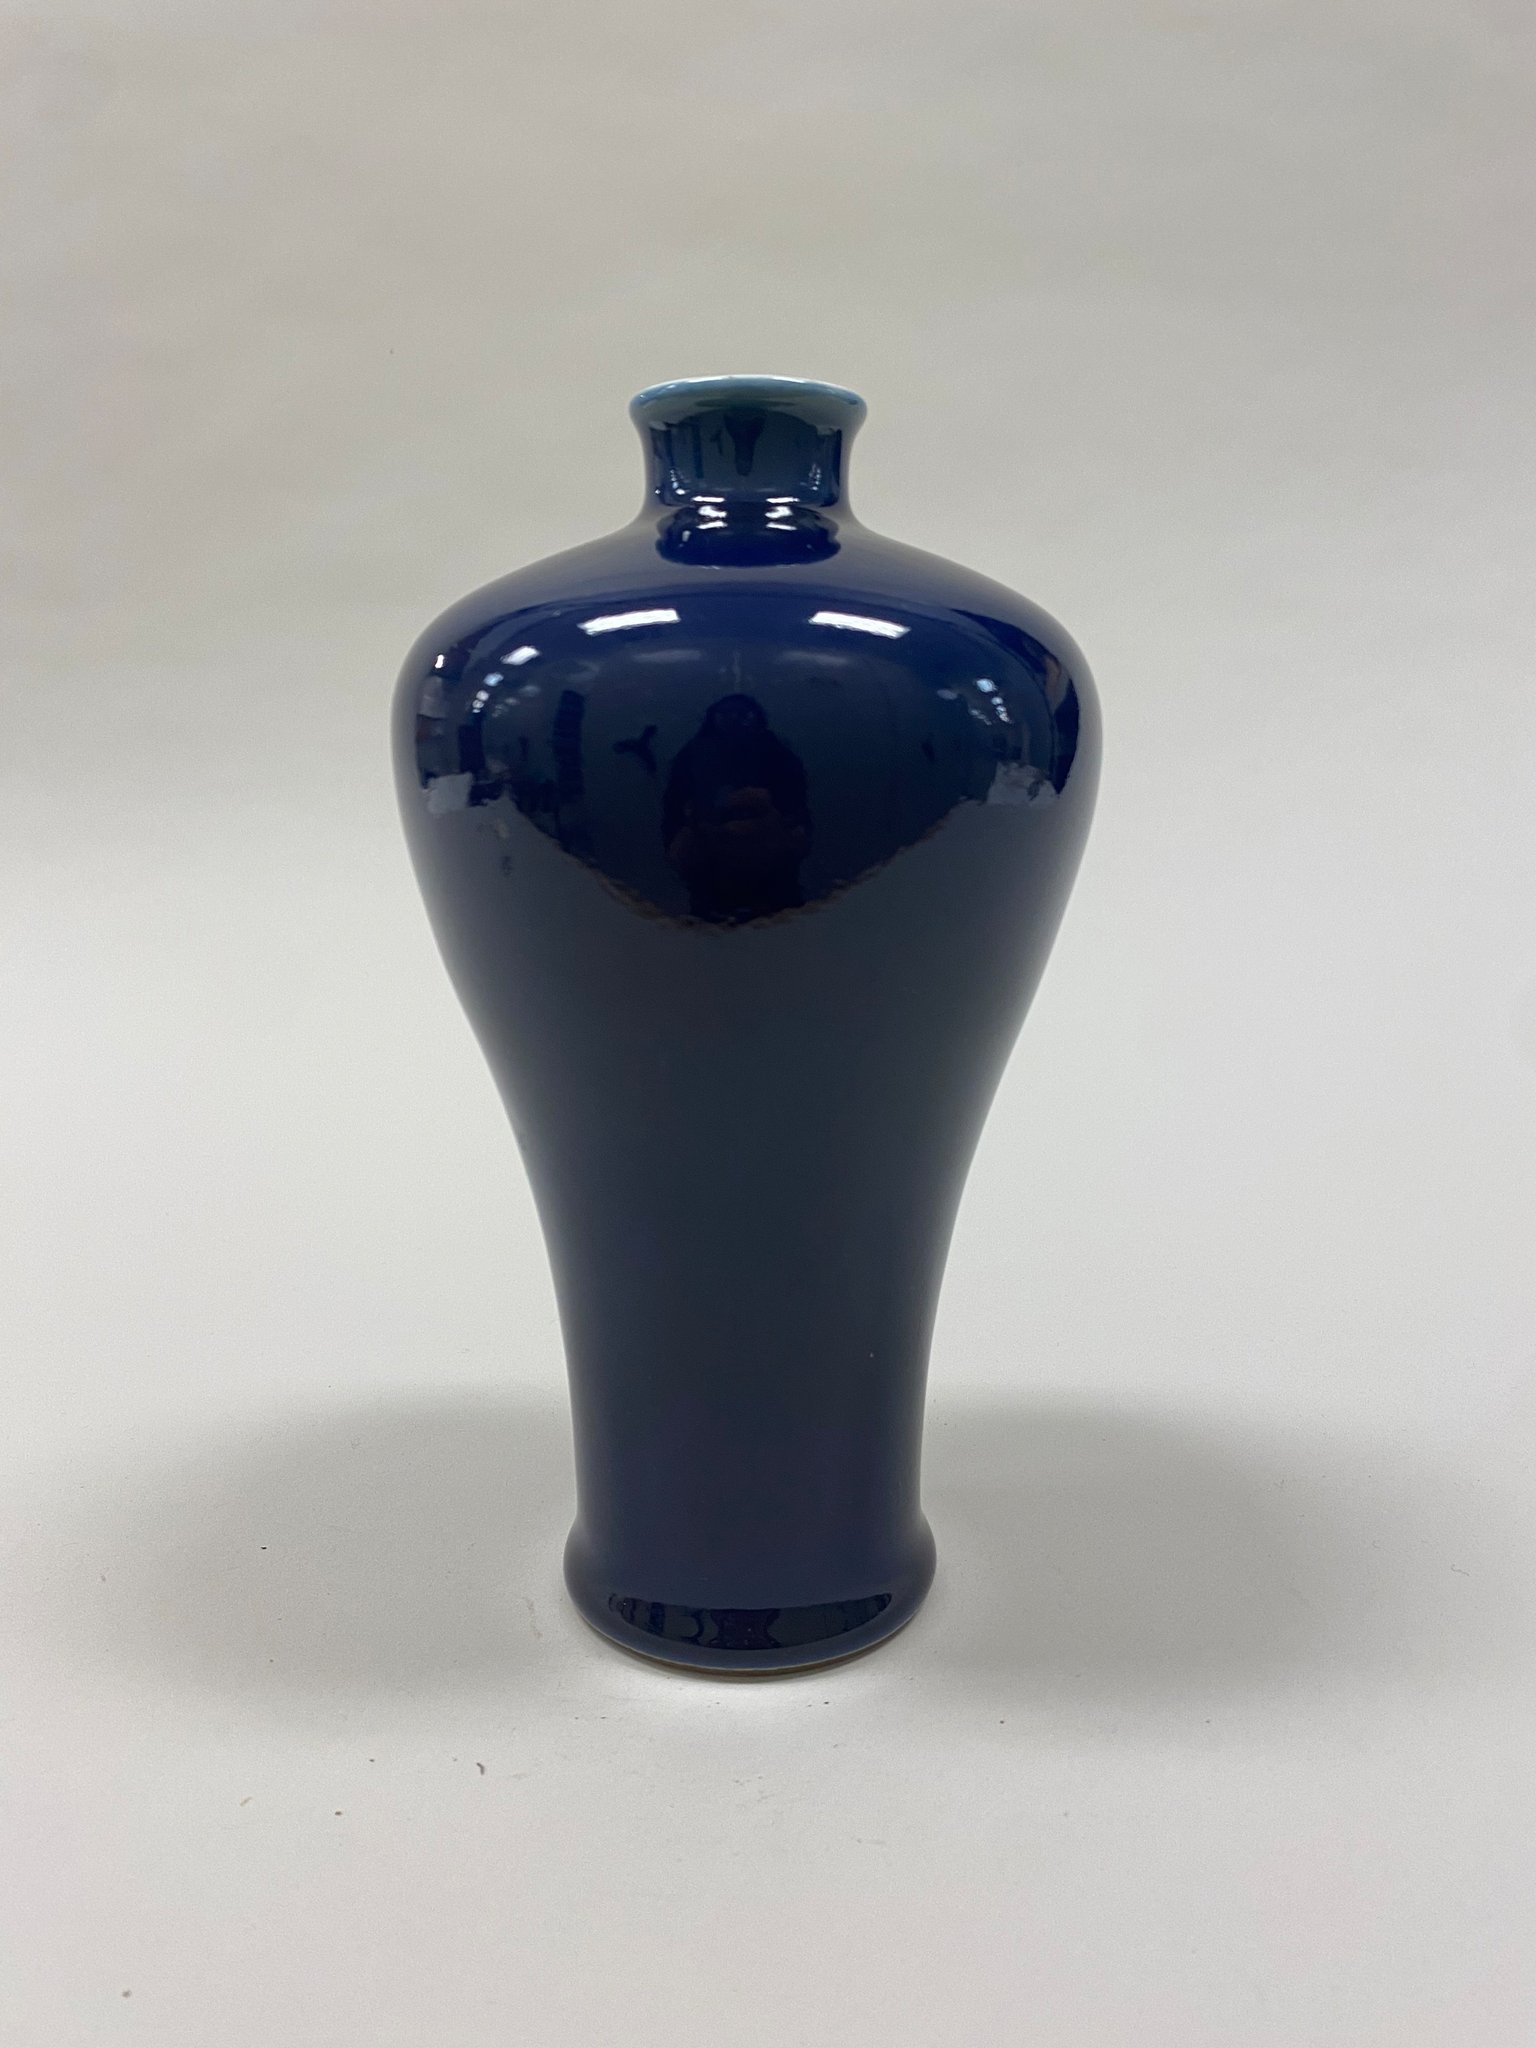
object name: gallipot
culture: chinese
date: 1701-1800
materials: glaze, porcelain